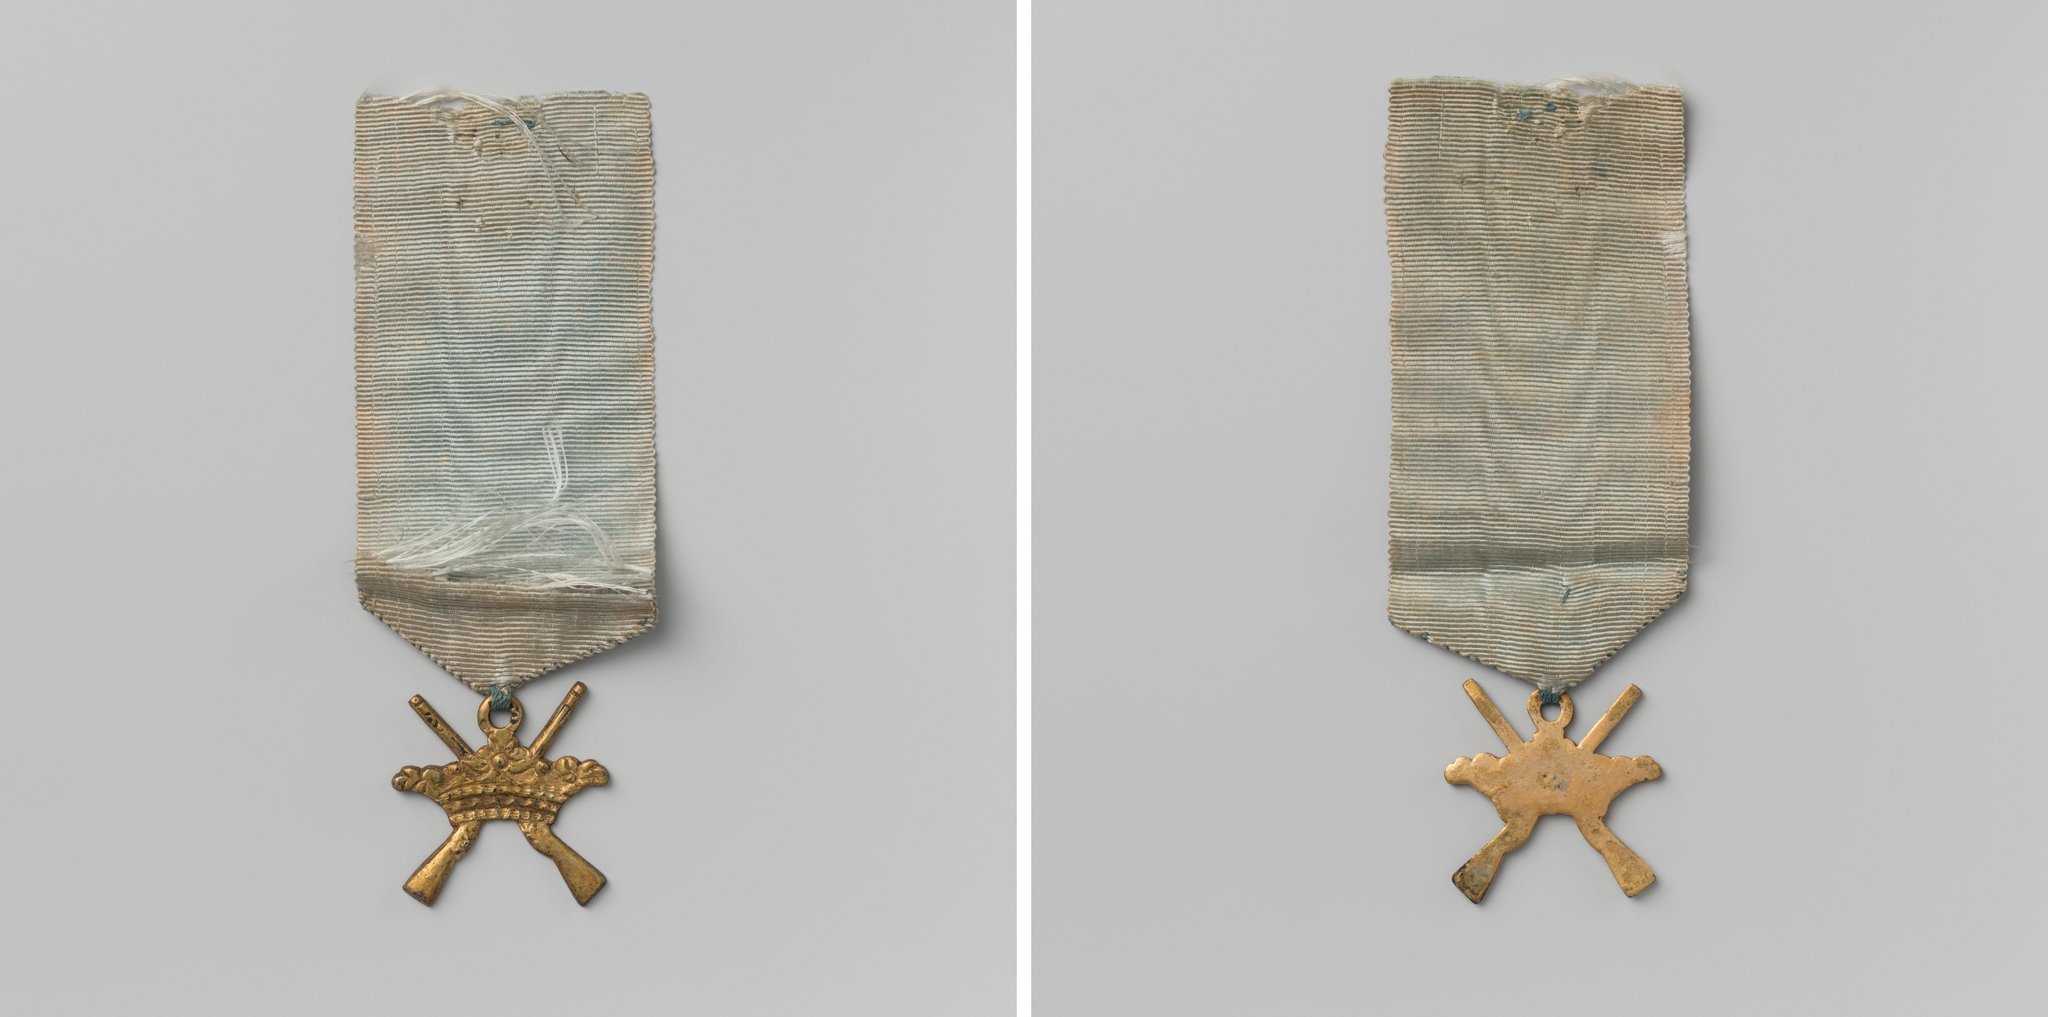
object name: insignia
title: Schutterij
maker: Anonymous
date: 1800-1875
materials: ribbon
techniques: casting, gilding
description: eenzijdig insigne in vorm van twee gekruiste geweren door kroon, aan lichtblauw lint